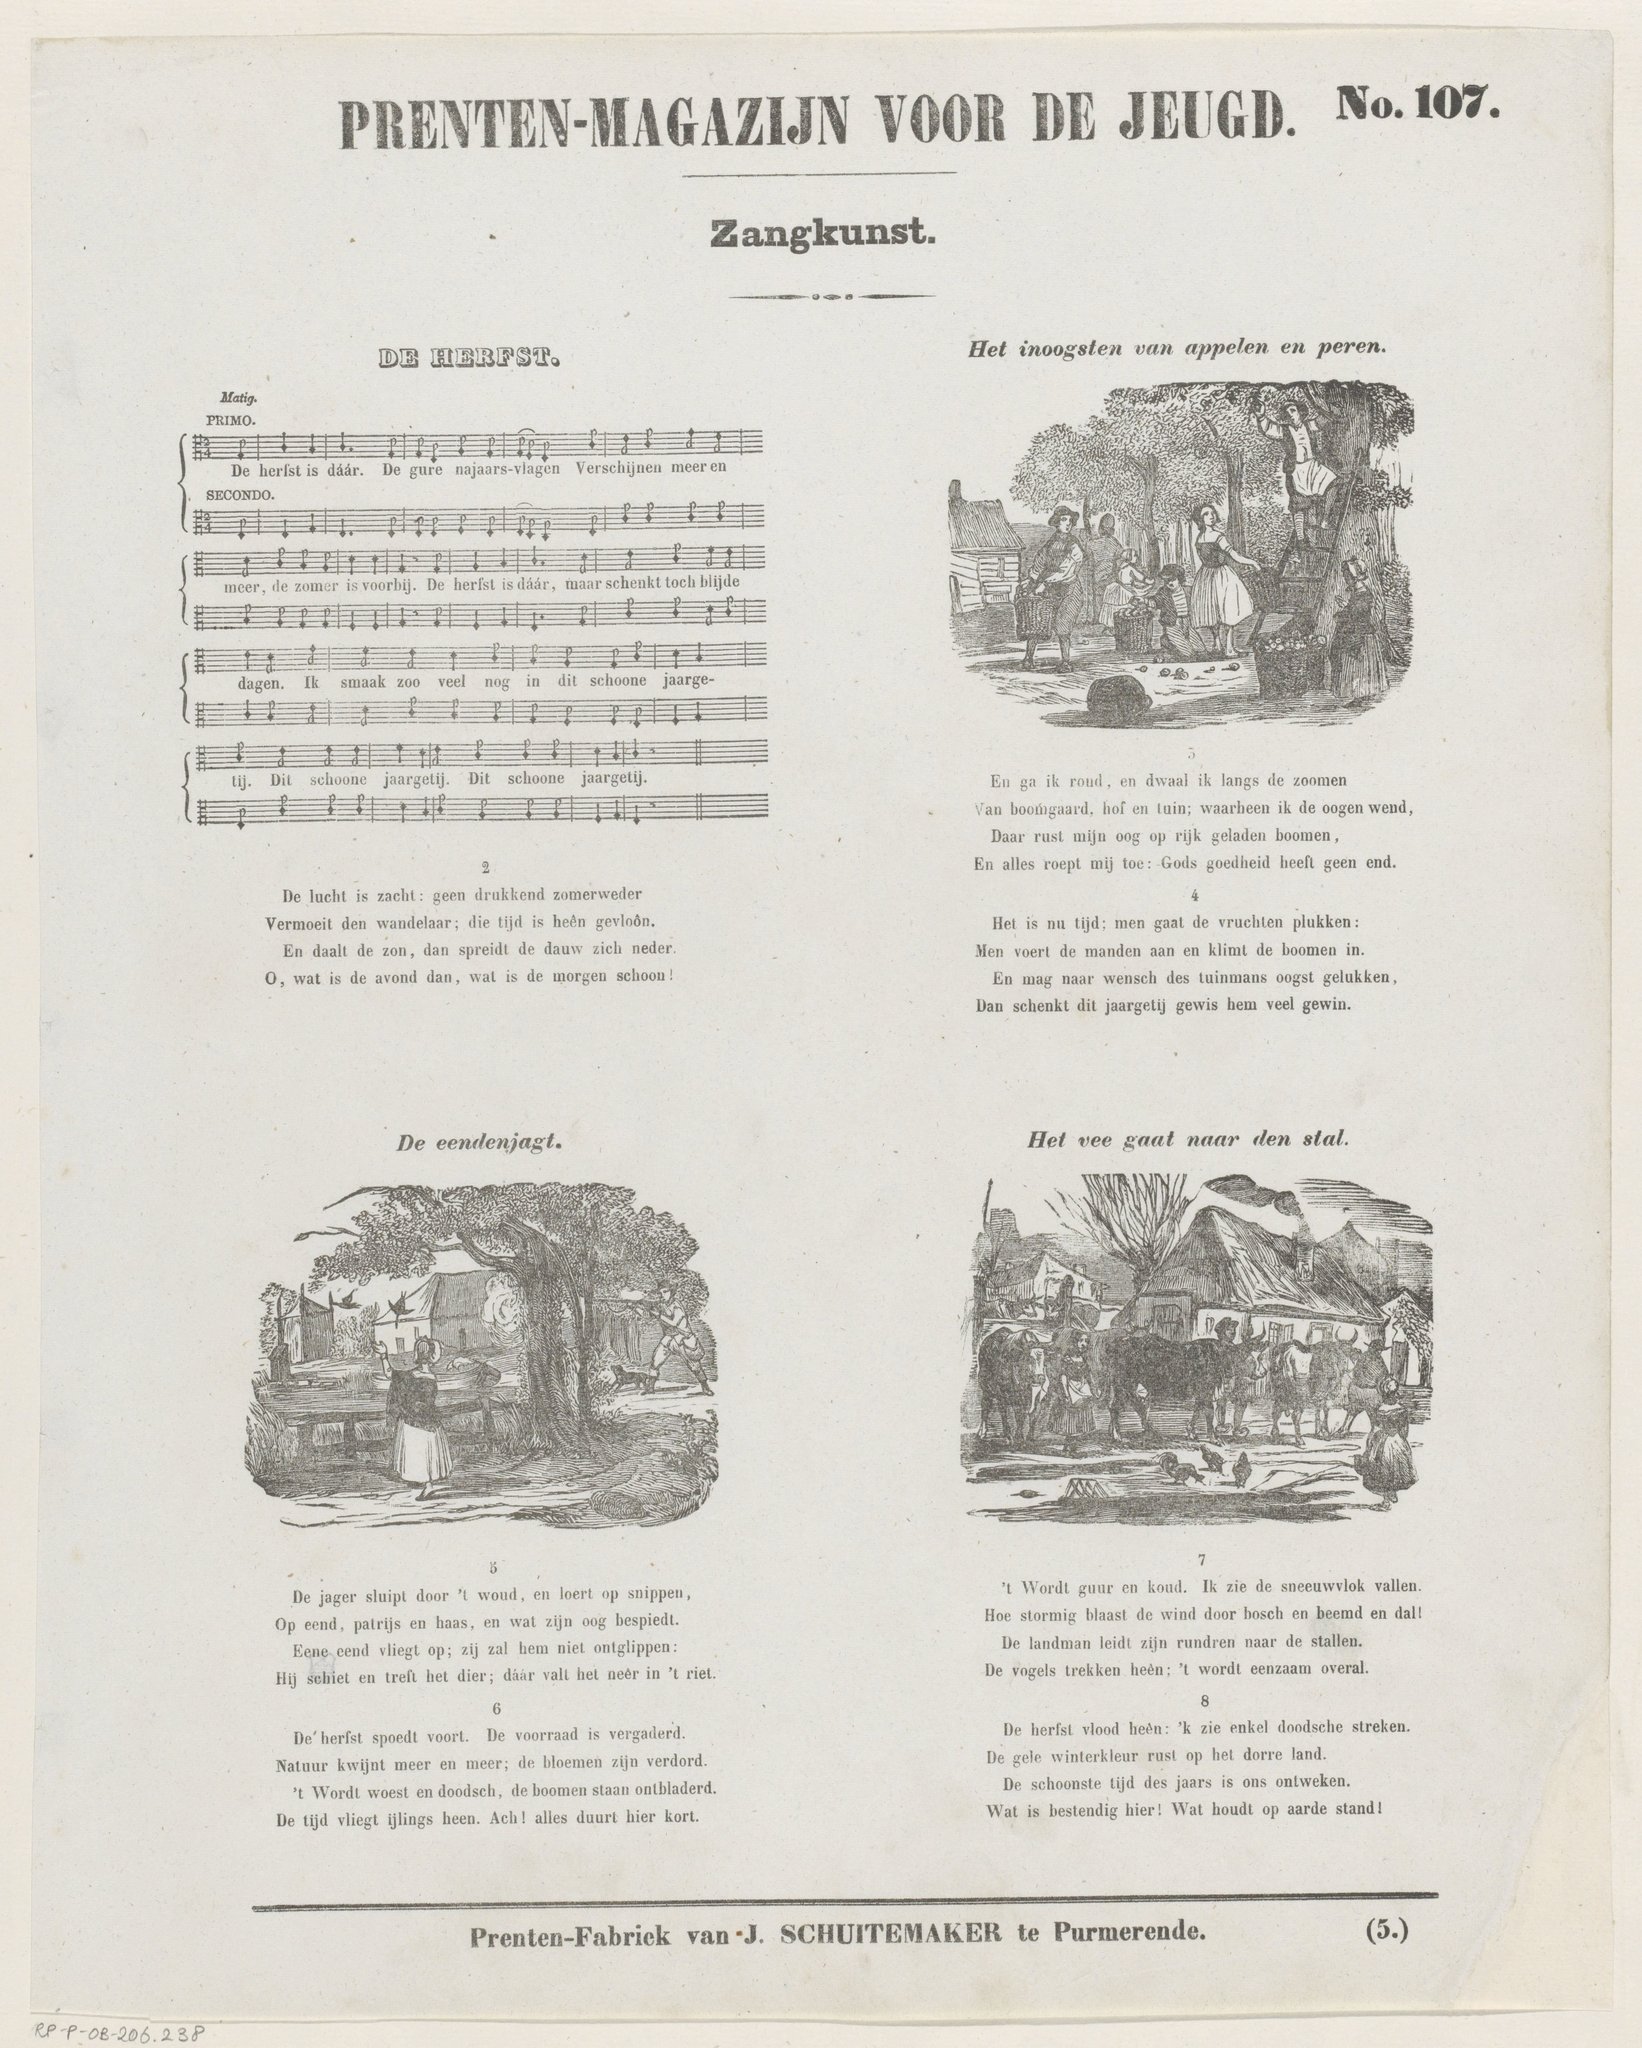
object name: popular print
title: Prenten-magazijn voor de jeugd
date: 1850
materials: paper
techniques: letterpress printing, engraving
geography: netherlands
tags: seasons of the year represented by scenes showing human activities, usually in a landscape, autumn ~ human activities (the four seasons of the year)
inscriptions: collector's mark: Lugt 2760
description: Na voltooiing van de acht jaargangen van de reeks 'Prenten-magazijn voor de jeugd' in 1850 heeft Jan Schuitemaker al deze prenten heruitgegeven en omgenummerd als nr. 1 t/m 192. De oorspronkelijke jaargang wordt telkens nog vermeld rechtsonder op de prent. Binnen de jaargangen zijn prenten van hetzelfde thema in clusters van vier achter elkaar gezet.